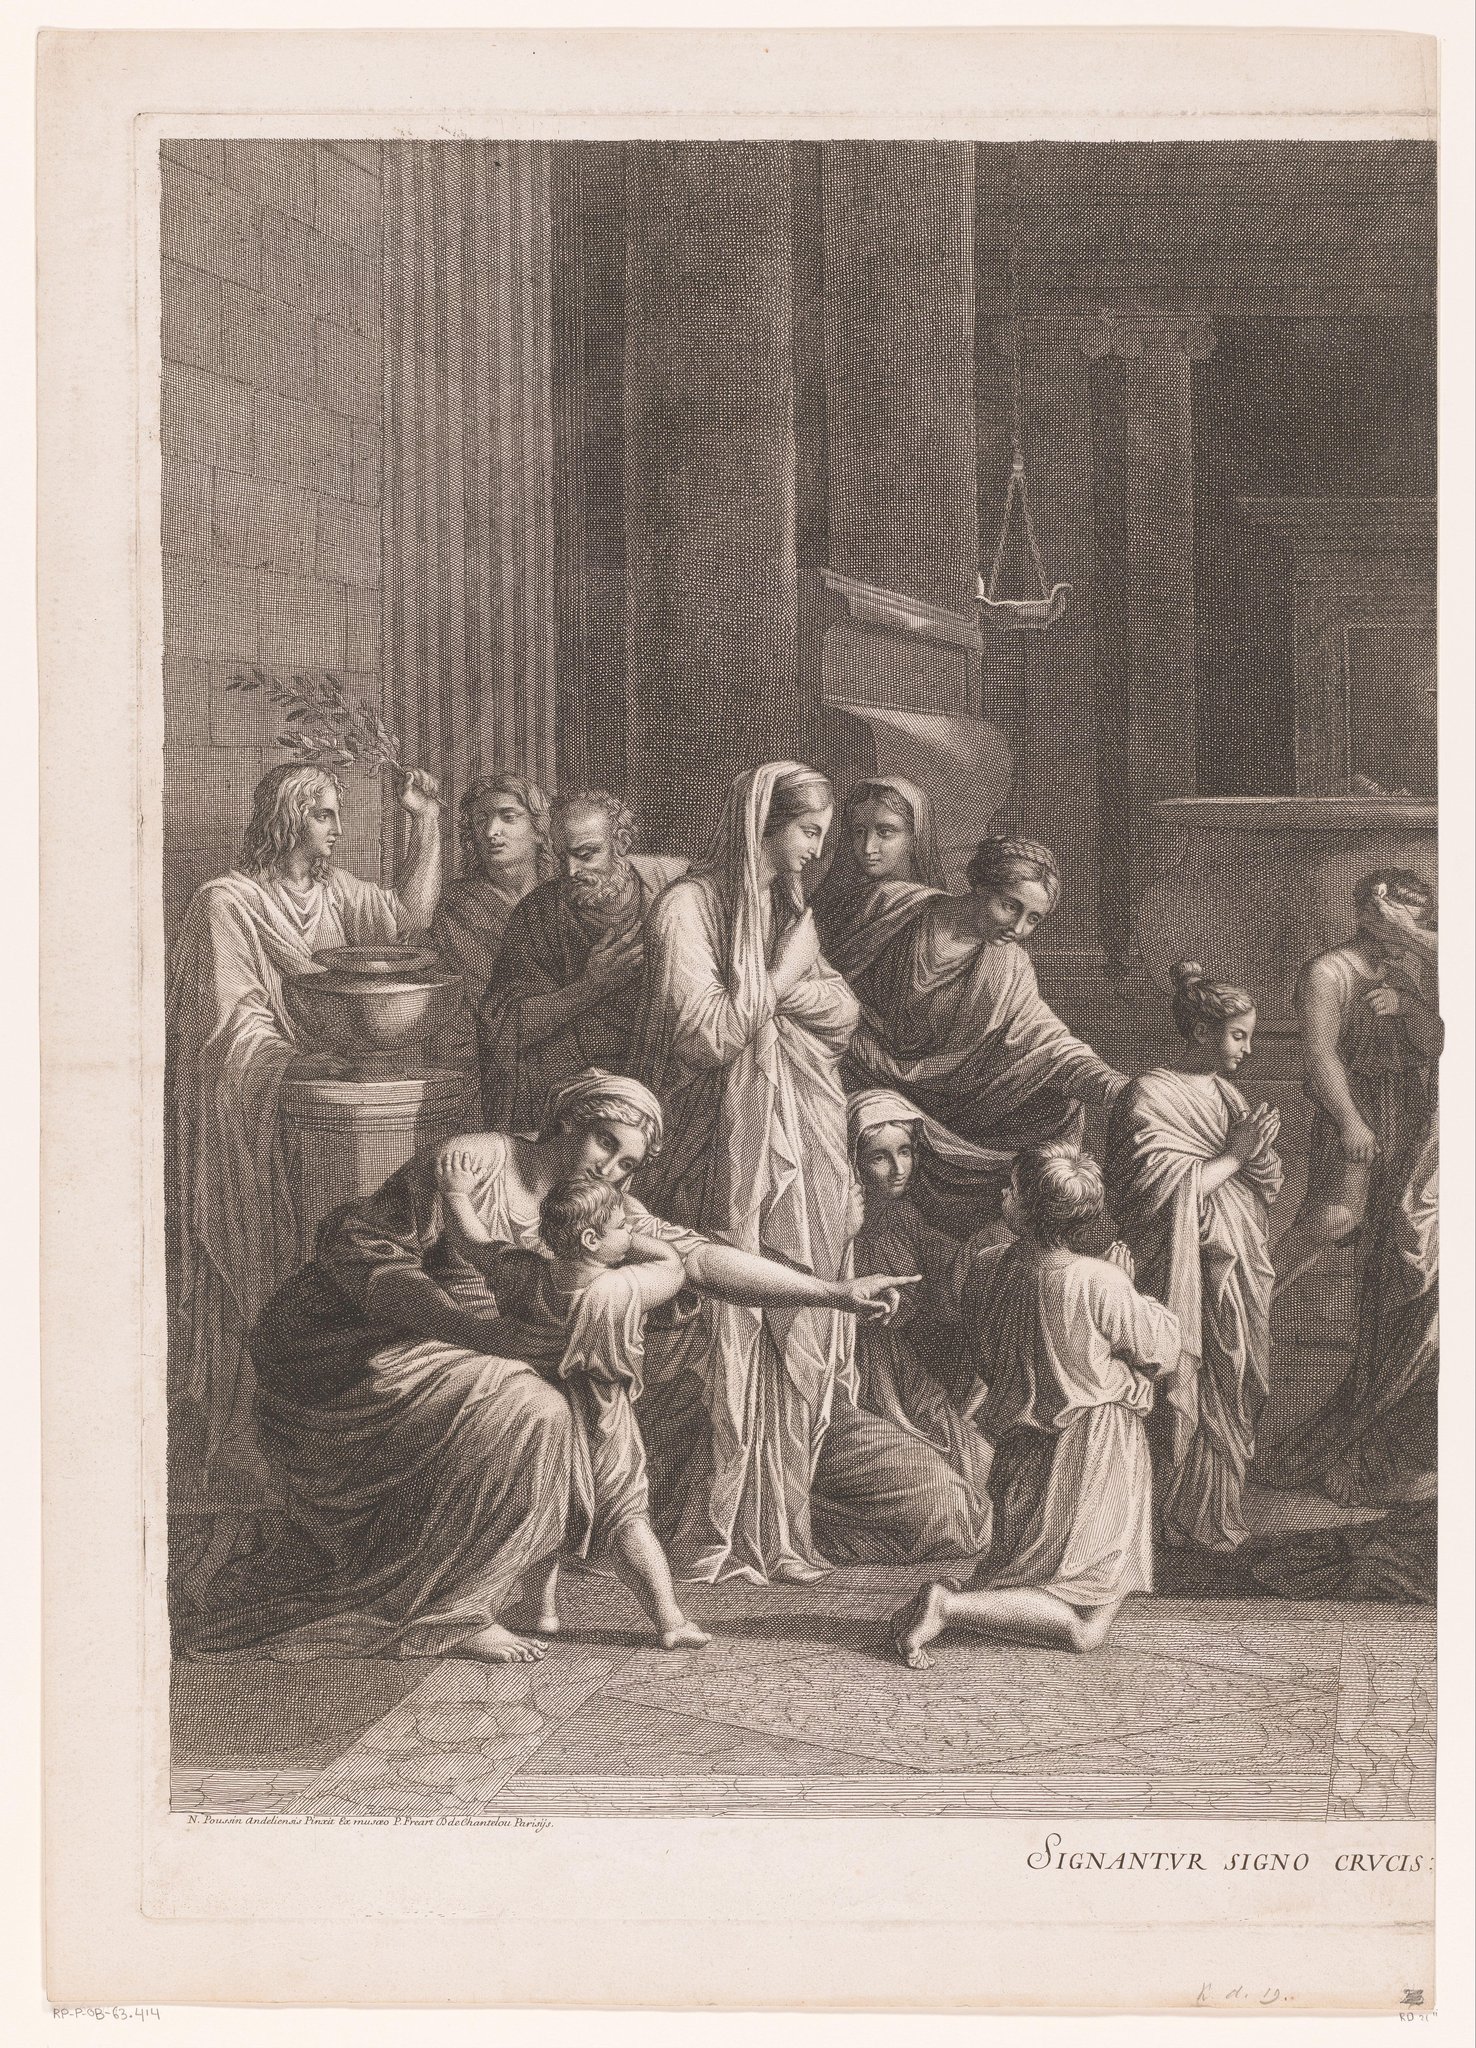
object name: print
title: Signantur signo crucis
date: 1633-1700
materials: paper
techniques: etching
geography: france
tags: confirmation ~ the second of the seven sacraments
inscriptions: collector's mark: Lugt 240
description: Prent maakt deel uit van een ongenummerde serie van zeven prenten.